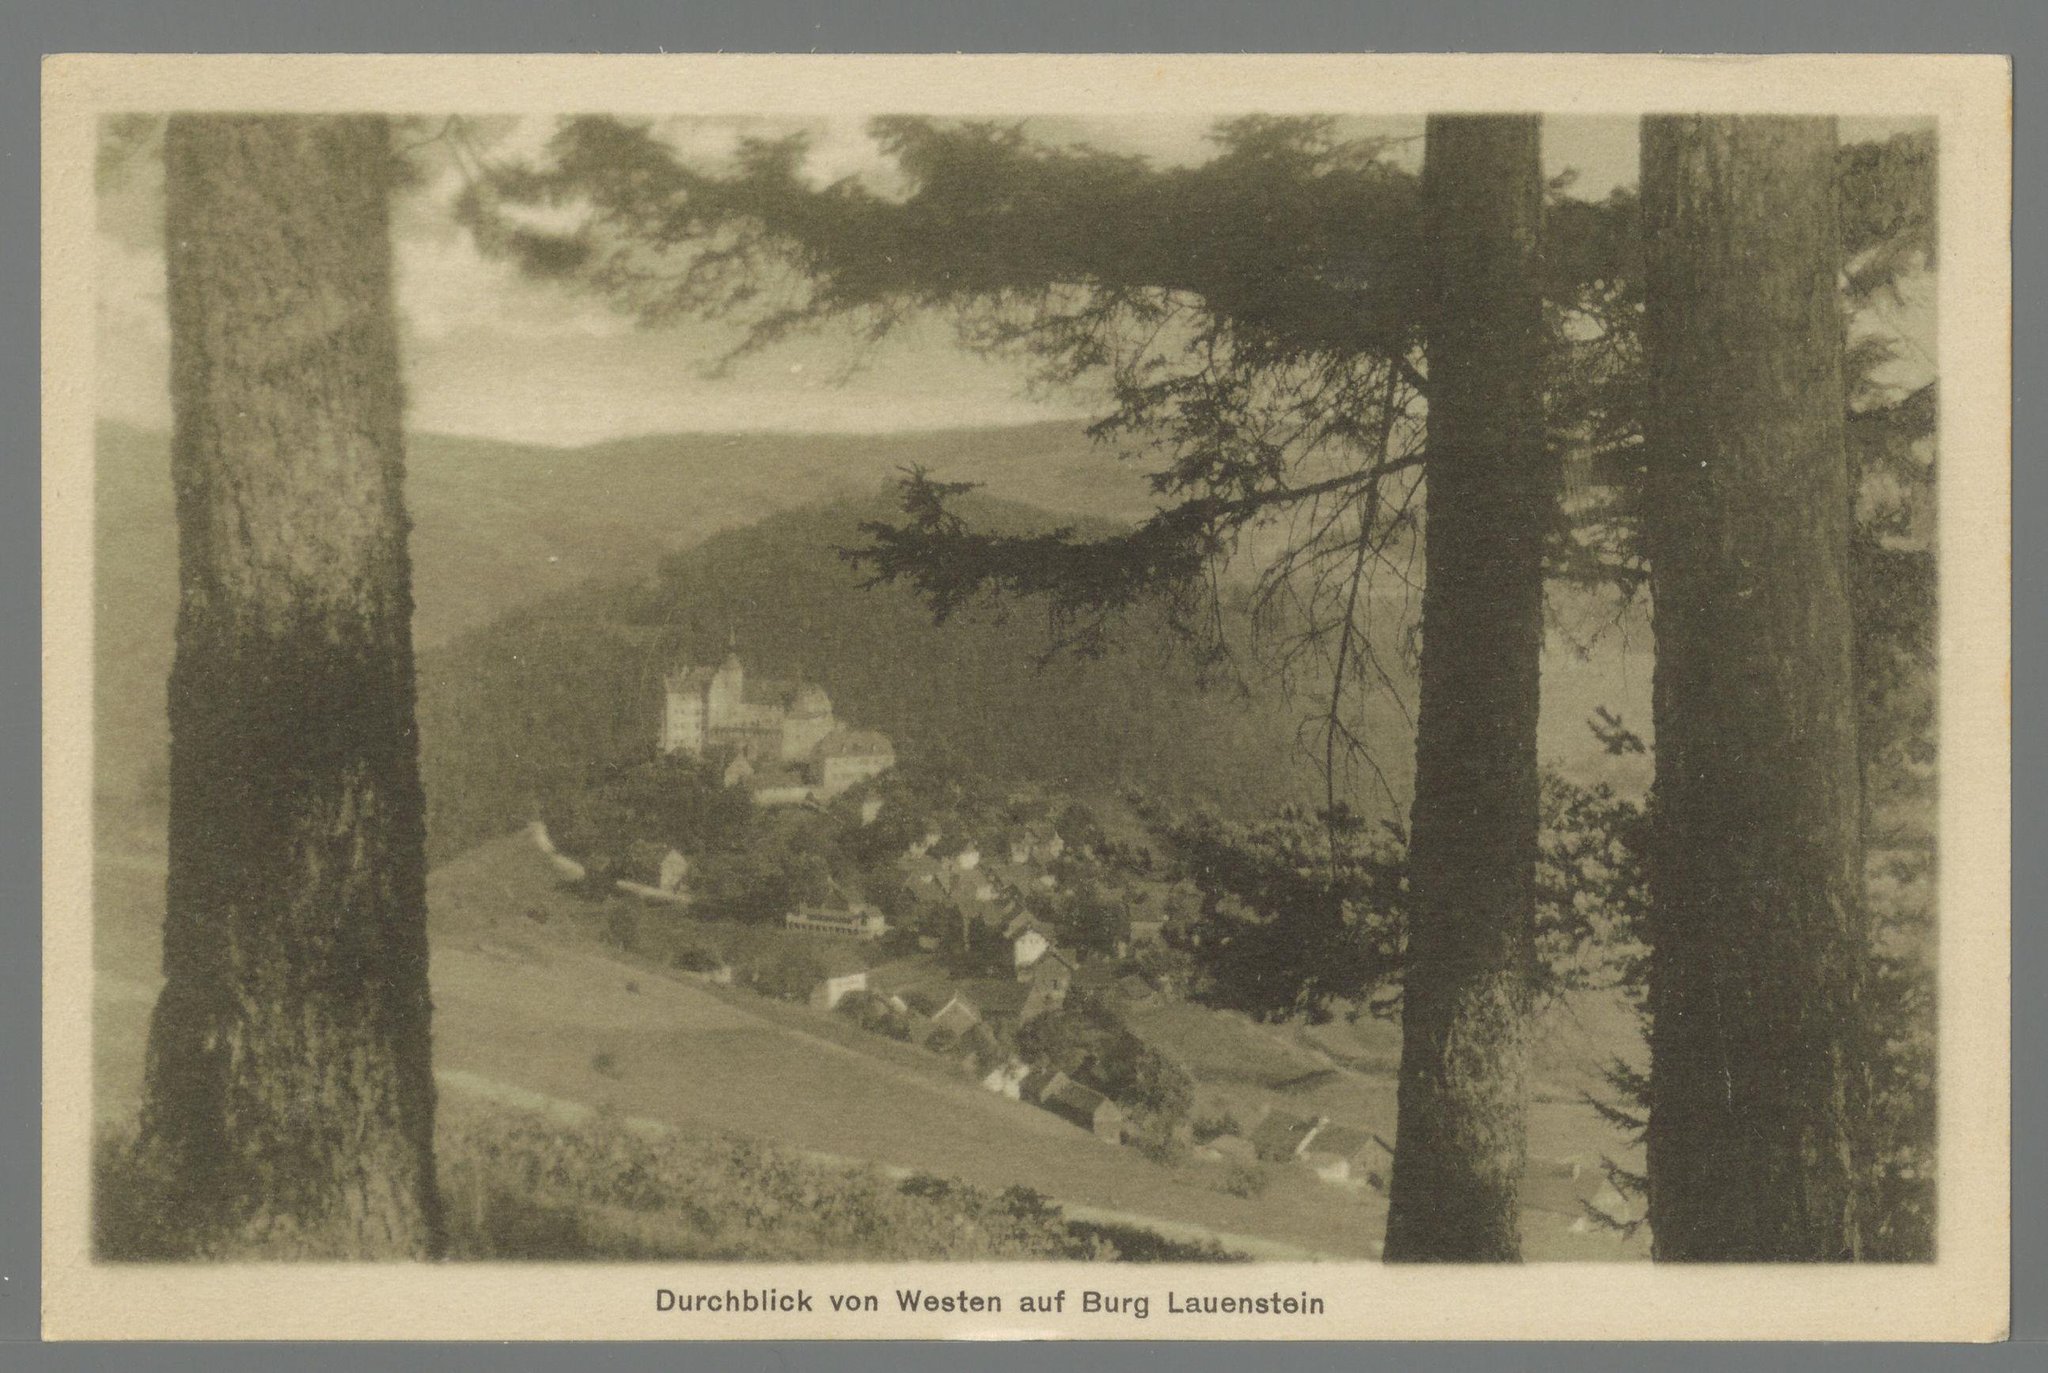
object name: ansichtkaart, prentbriefkaart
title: Durchblick von Westen auf Burg Lauenstein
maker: Anonymous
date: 1905-1930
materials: cardboard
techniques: photograph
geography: ludwigsstadt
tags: castle